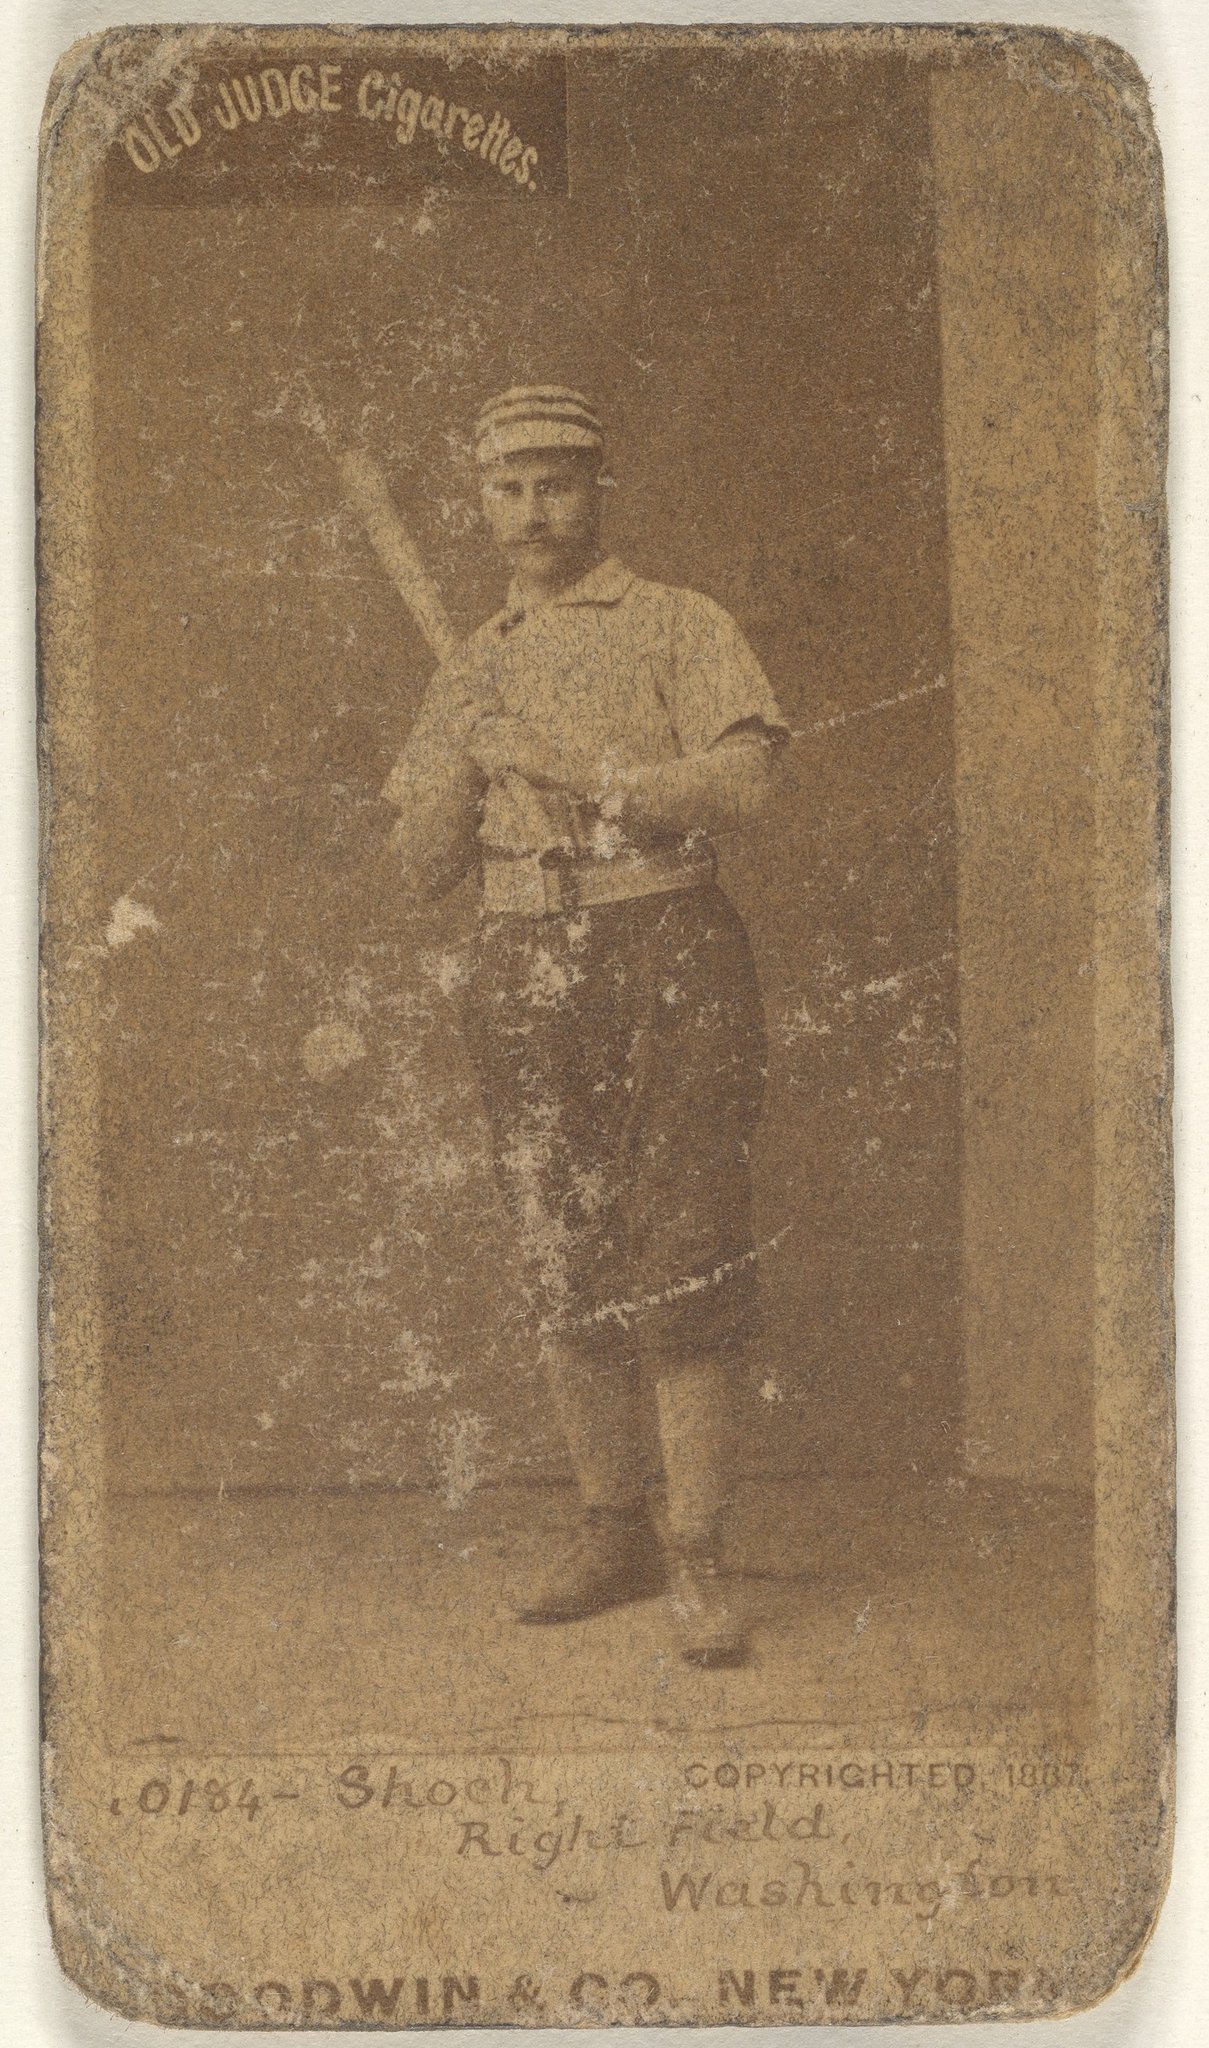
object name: baseball card, photograph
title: George Quintus Shoch, Right Field, Washington Nationals, from the Old Judge series (N172) for Old Judge Cigarettes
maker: goodwin & company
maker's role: publisher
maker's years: 1850-1950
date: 1887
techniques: albumen silver print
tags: men,portraits,baseball,athletes